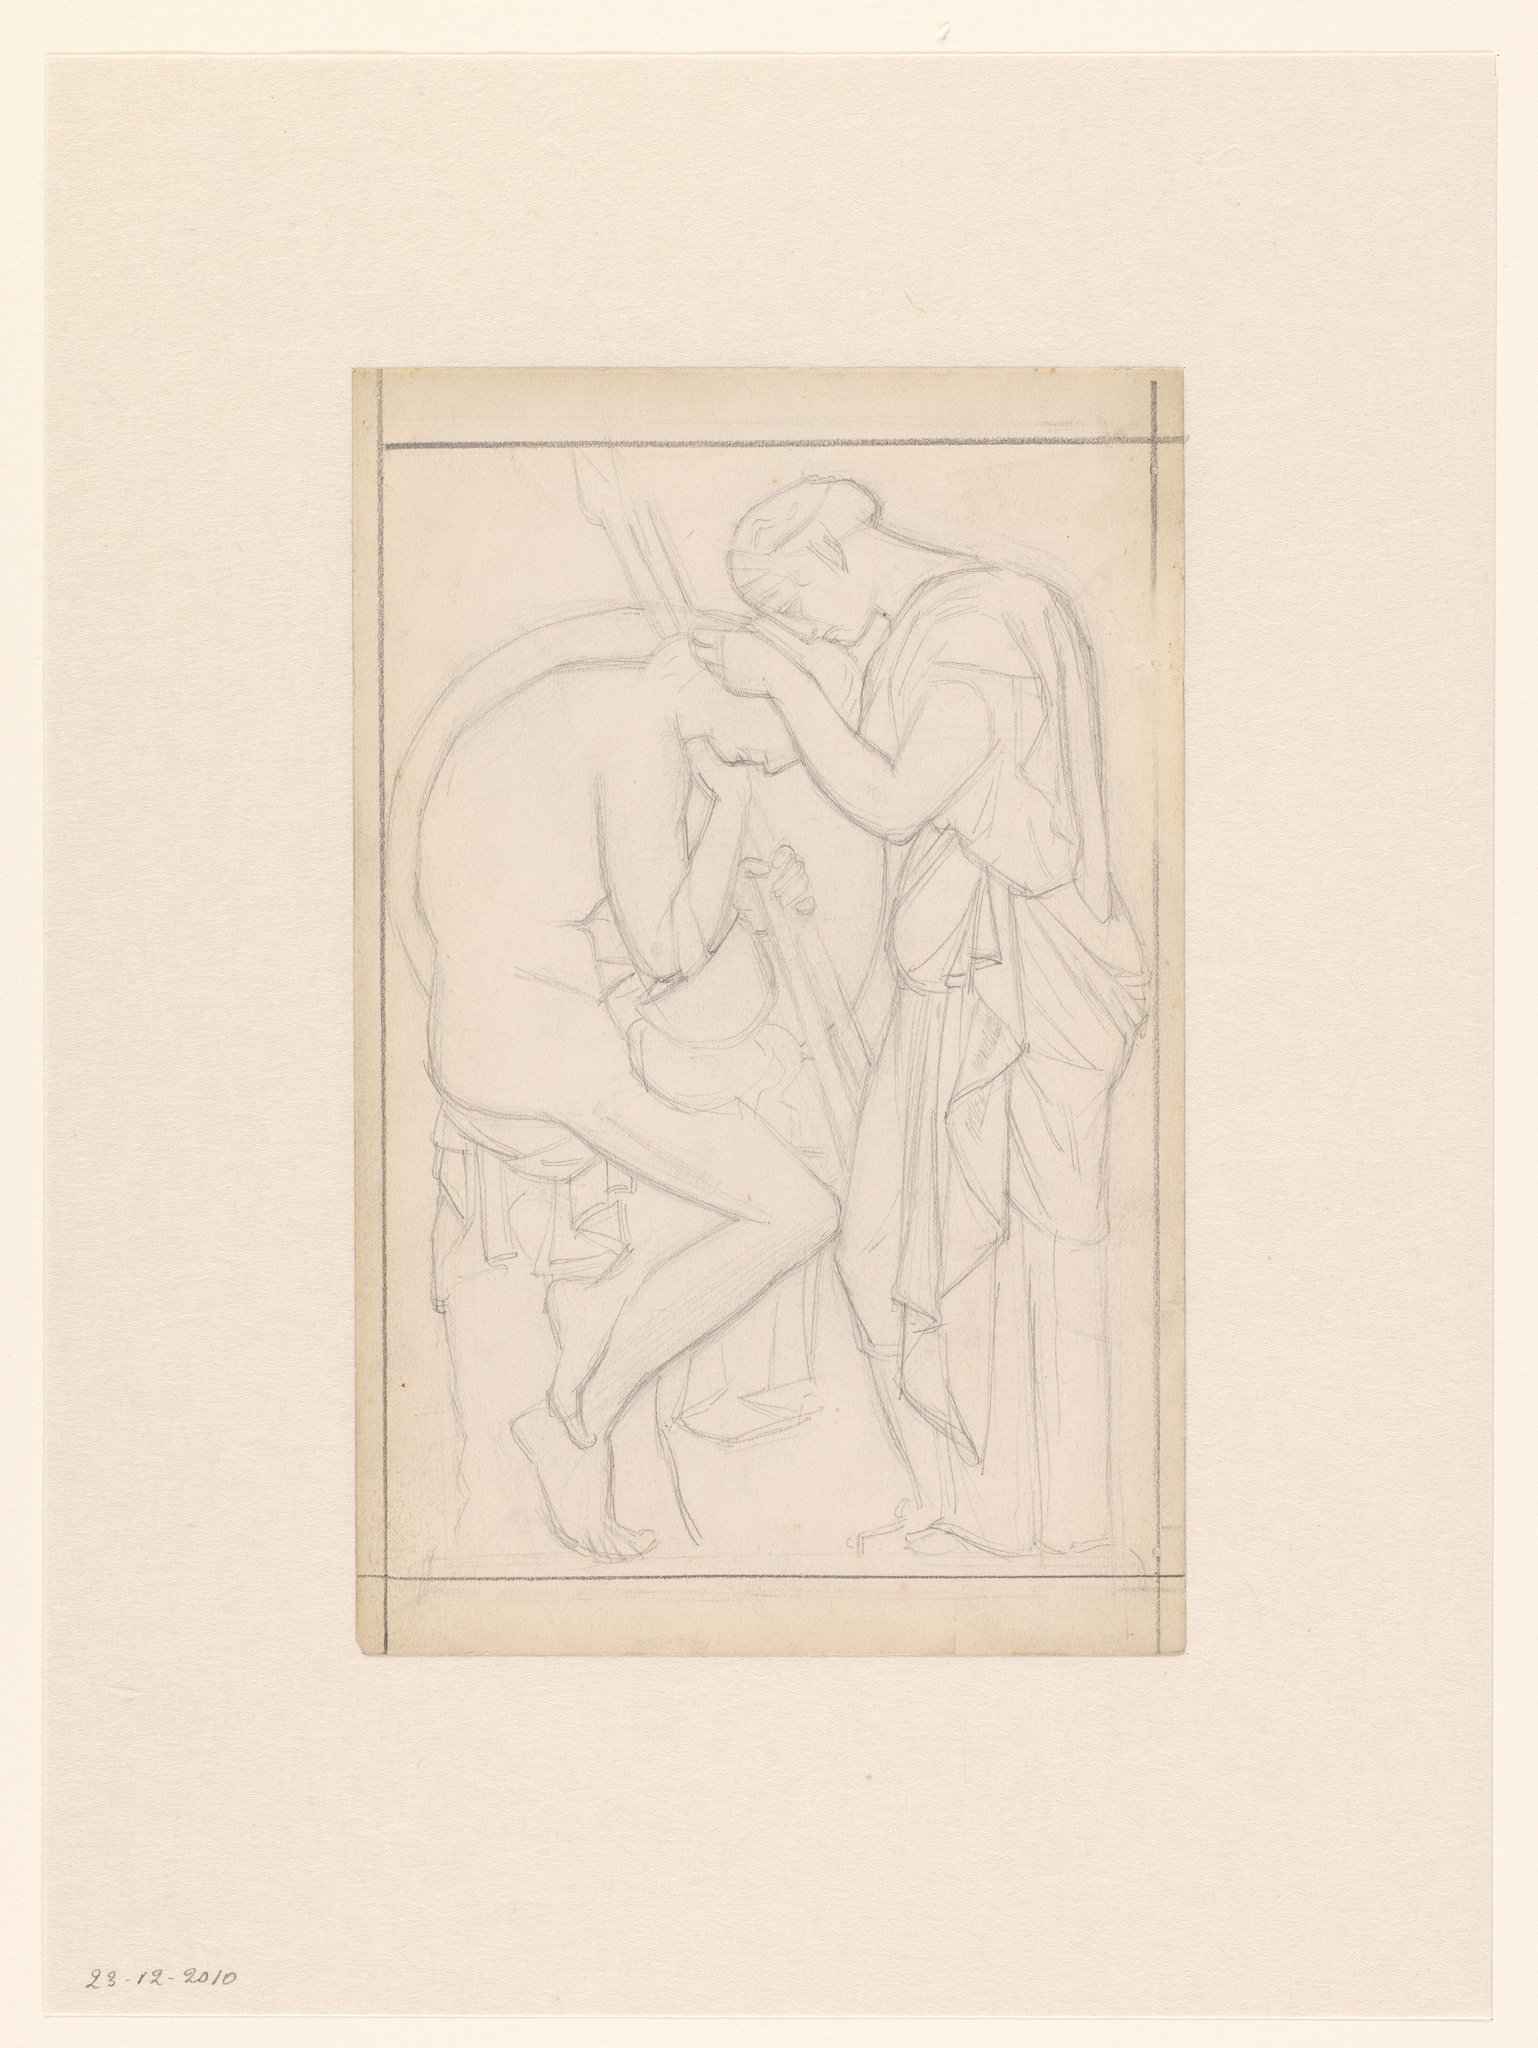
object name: drawing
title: Griekse krijger met zijn vrouw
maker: jan veth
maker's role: designer, draughtsman, painter, print maker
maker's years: 1864-1925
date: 1874-1925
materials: paper, pencil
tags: griekenland